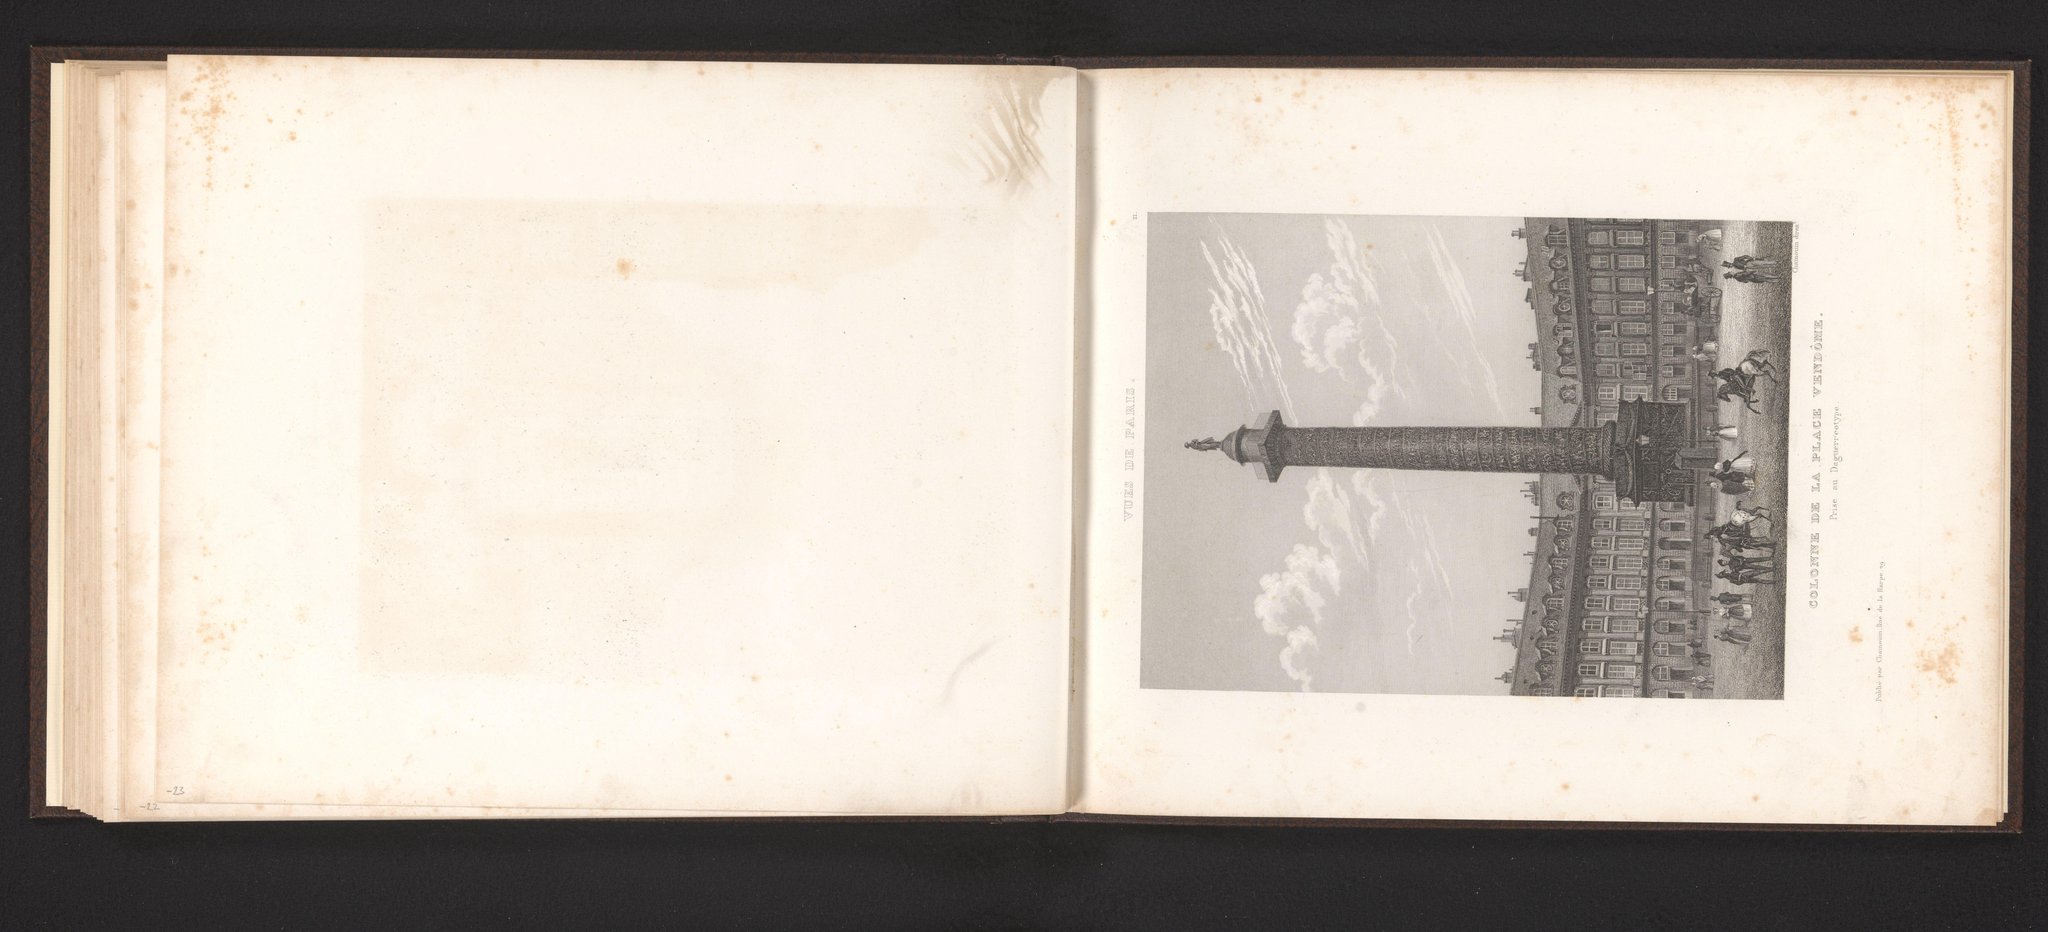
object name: page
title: Colonne de la Place Vendôme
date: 1845-1850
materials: paper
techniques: engraving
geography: paris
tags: square, place, circus, etc., obelisk, needle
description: Prent op vierentwintigste ongenummerde pagina na titelpagina. Prent gemaakt naar daguerreotypie.